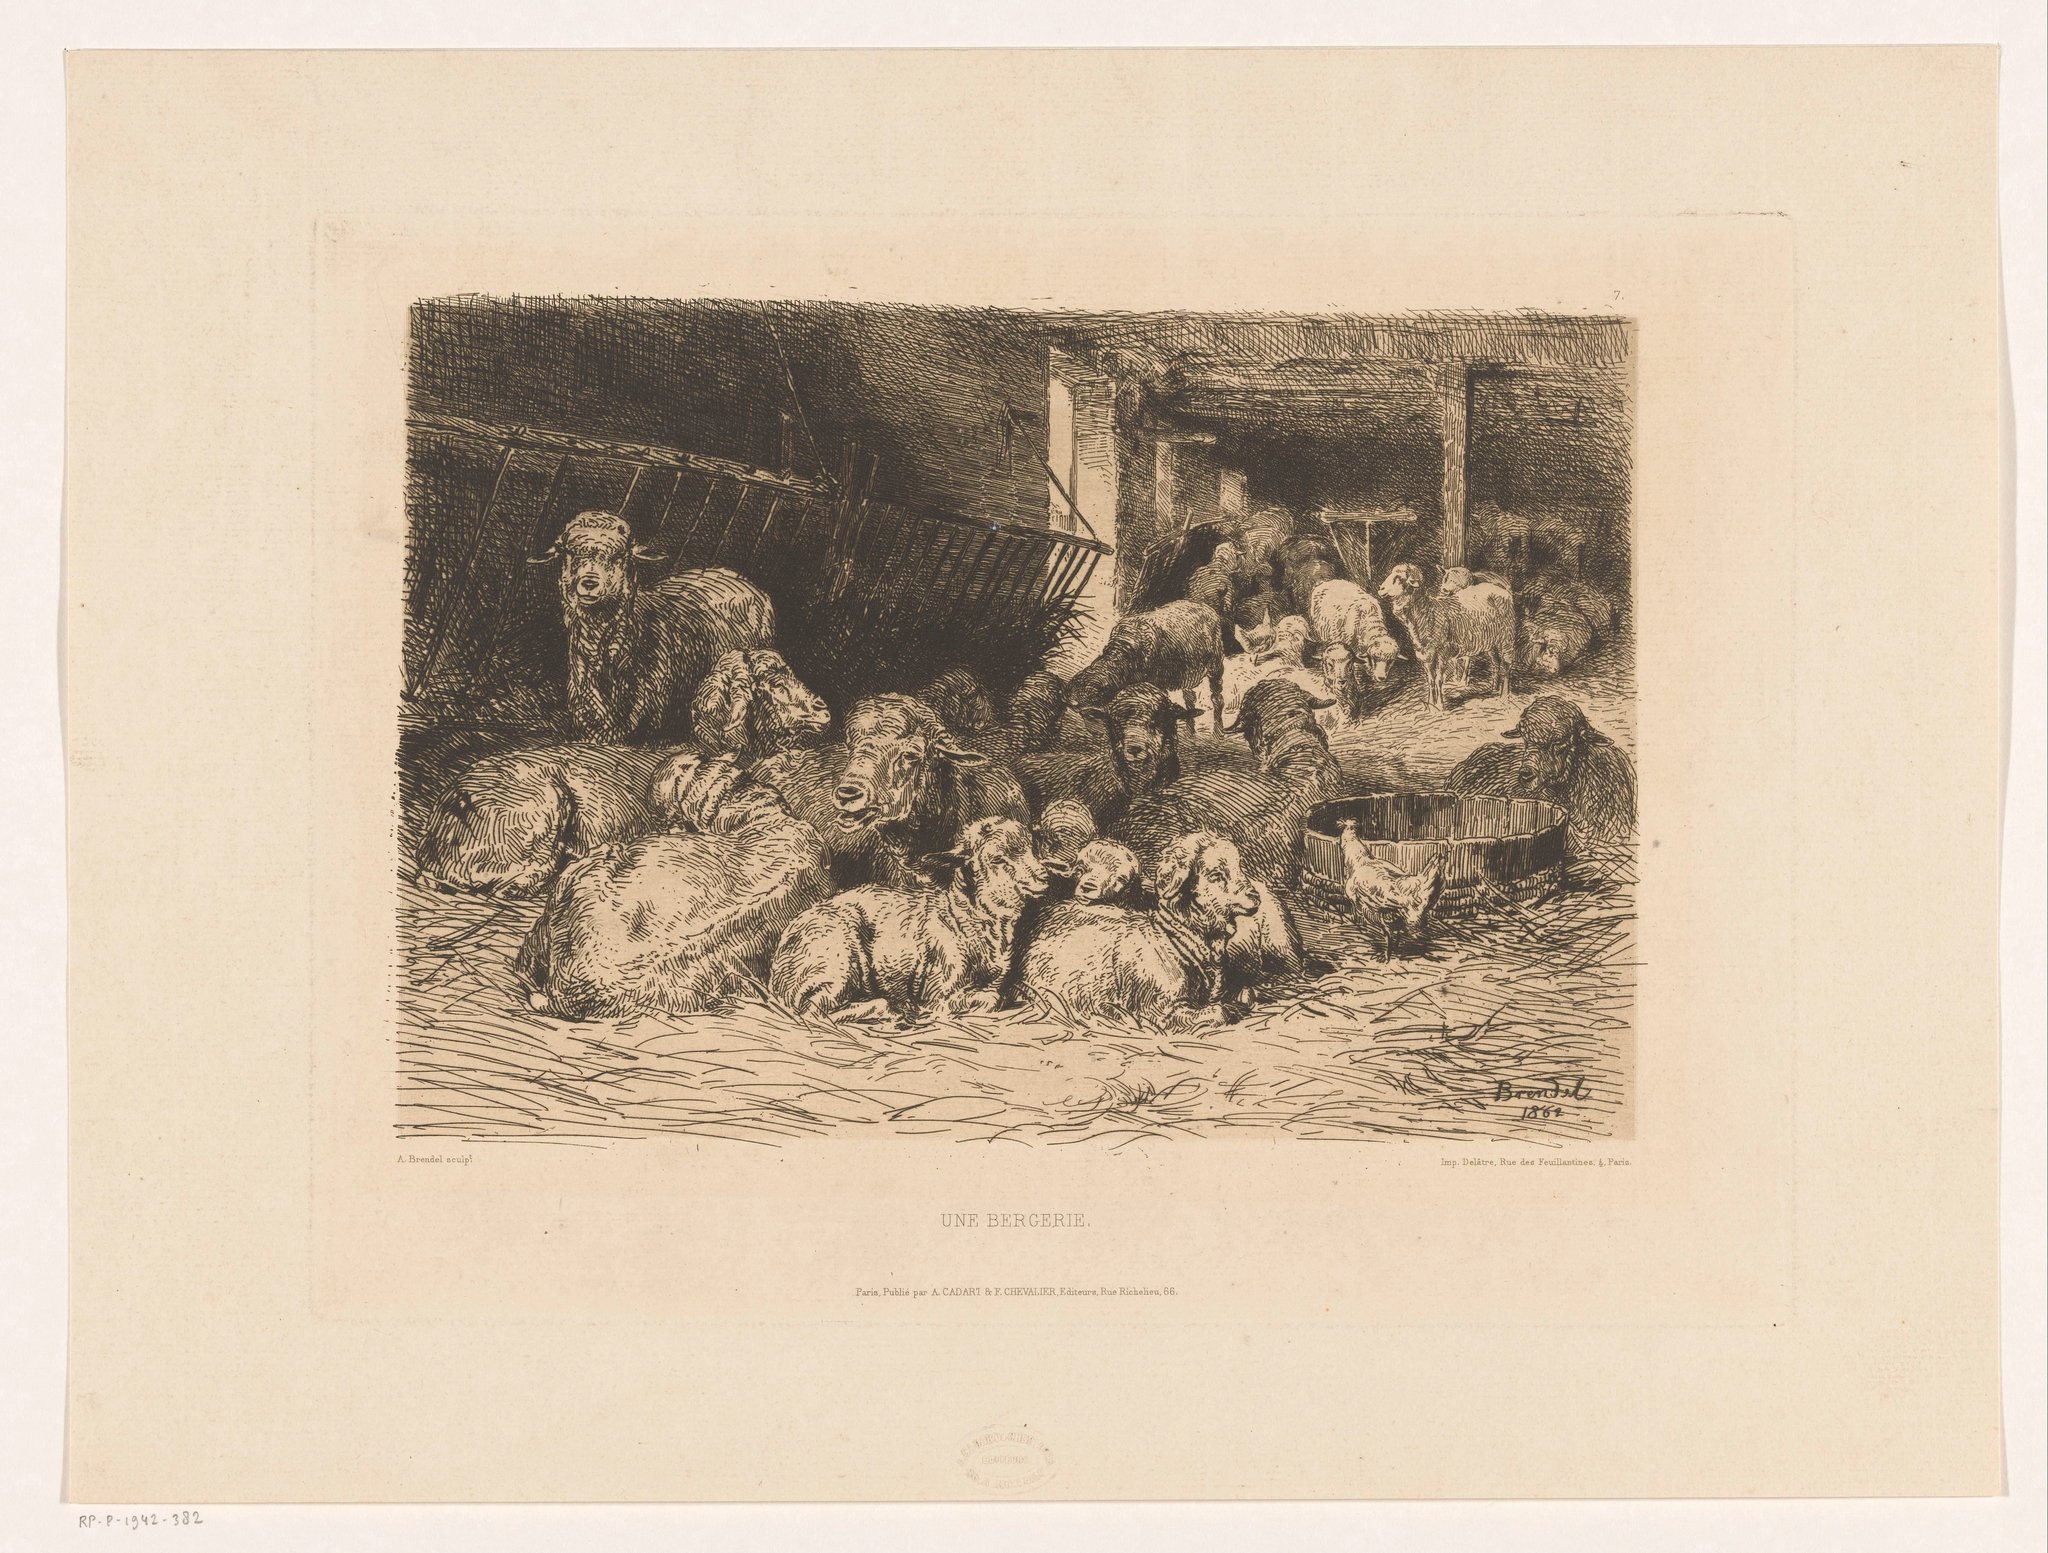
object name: print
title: Interieur van een schaapskooi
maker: albert heinrich brendel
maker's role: print maker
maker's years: 1827-1895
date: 1862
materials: paper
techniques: etching, intaglio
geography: paris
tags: barn - aa - civic architecture: inside, sheep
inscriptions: collector's mark: Lugt 2228, check stamp: Lugt 3270, collector's mark: Lugt 2760